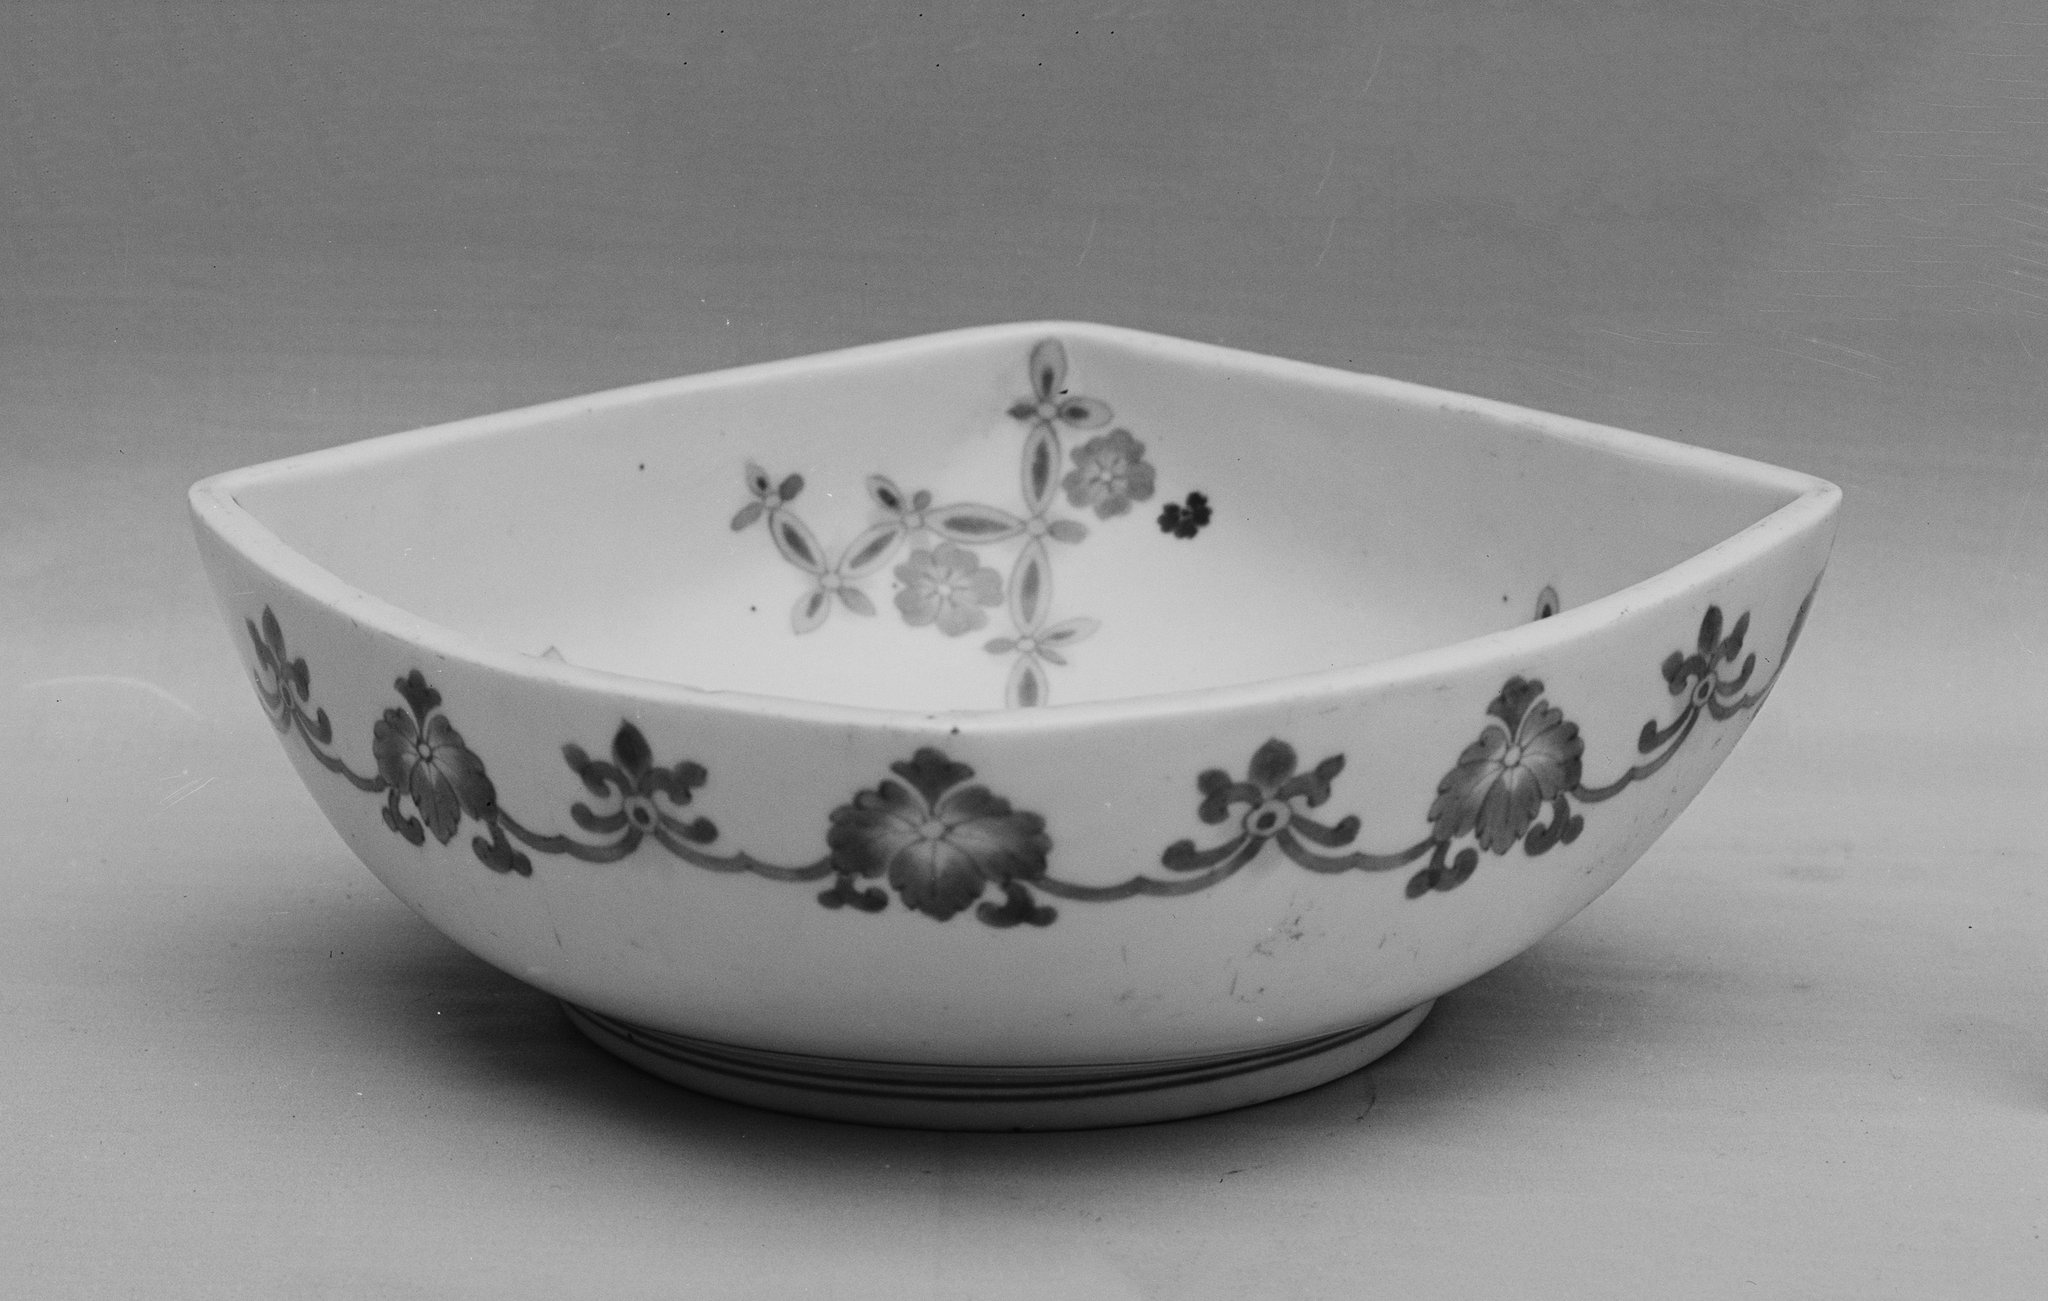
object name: bowl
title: Square Bowl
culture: japanese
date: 1780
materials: enamel, glaze, porcelain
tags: flowers